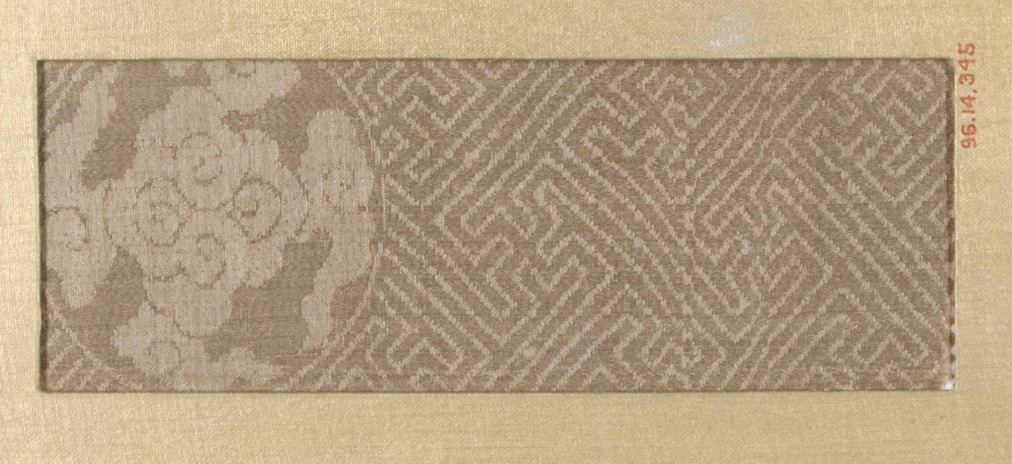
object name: piece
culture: japanese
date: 1701-1900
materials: silk